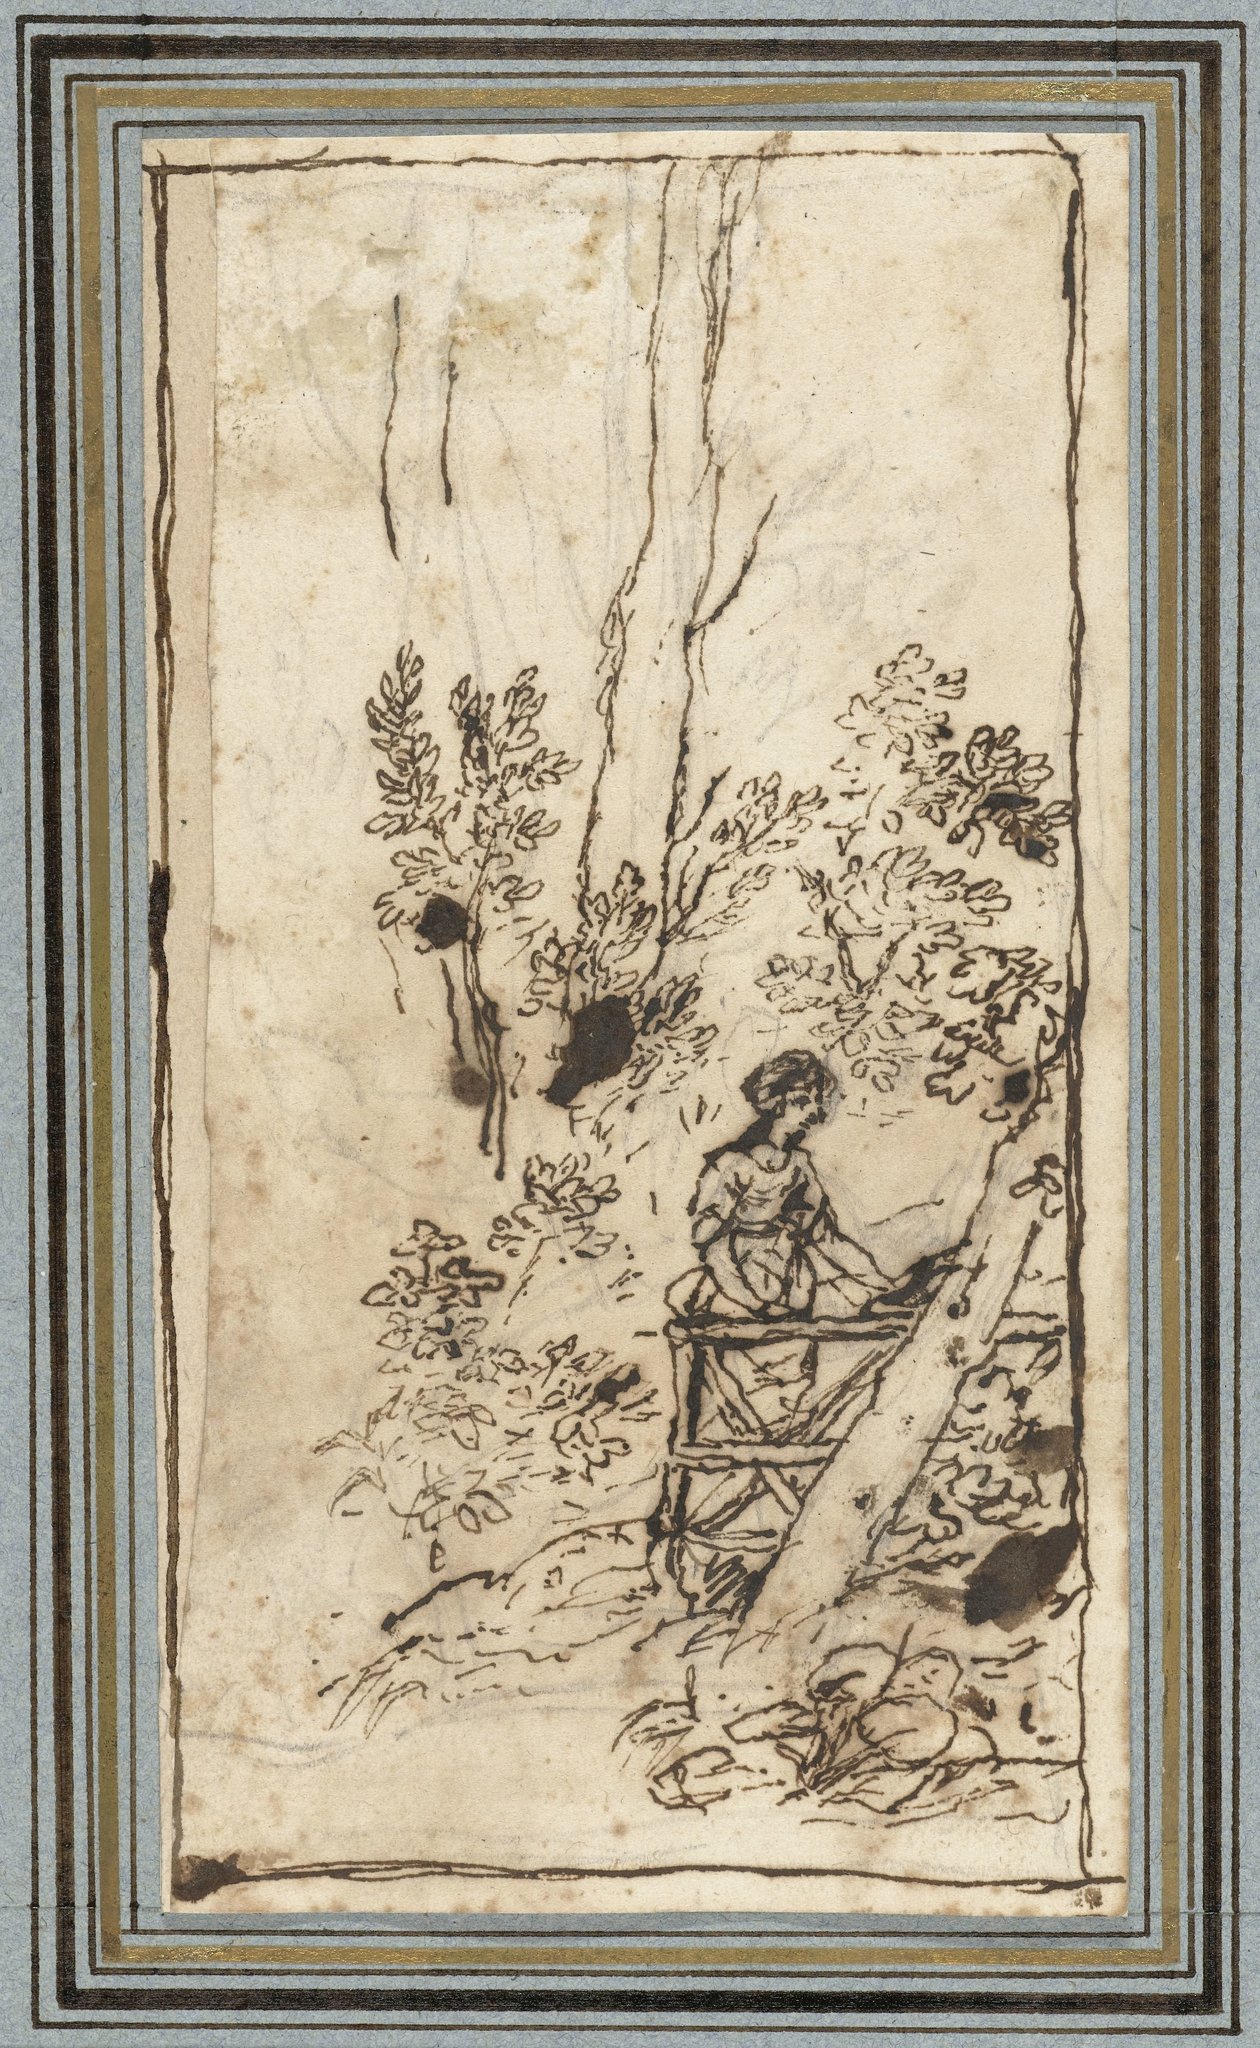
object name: drawing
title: Jonge vrouw staande bij een hek in een bos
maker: claude lorrain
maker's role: draughtsman, print maker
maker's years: 1604-1682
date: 1665-1670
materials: ink, paper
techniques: pen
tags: adolescent, young woman, maiden, fence, wall, paling, forest, wood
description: Studies van dieren uit het zogenaamde Dierenalbum.